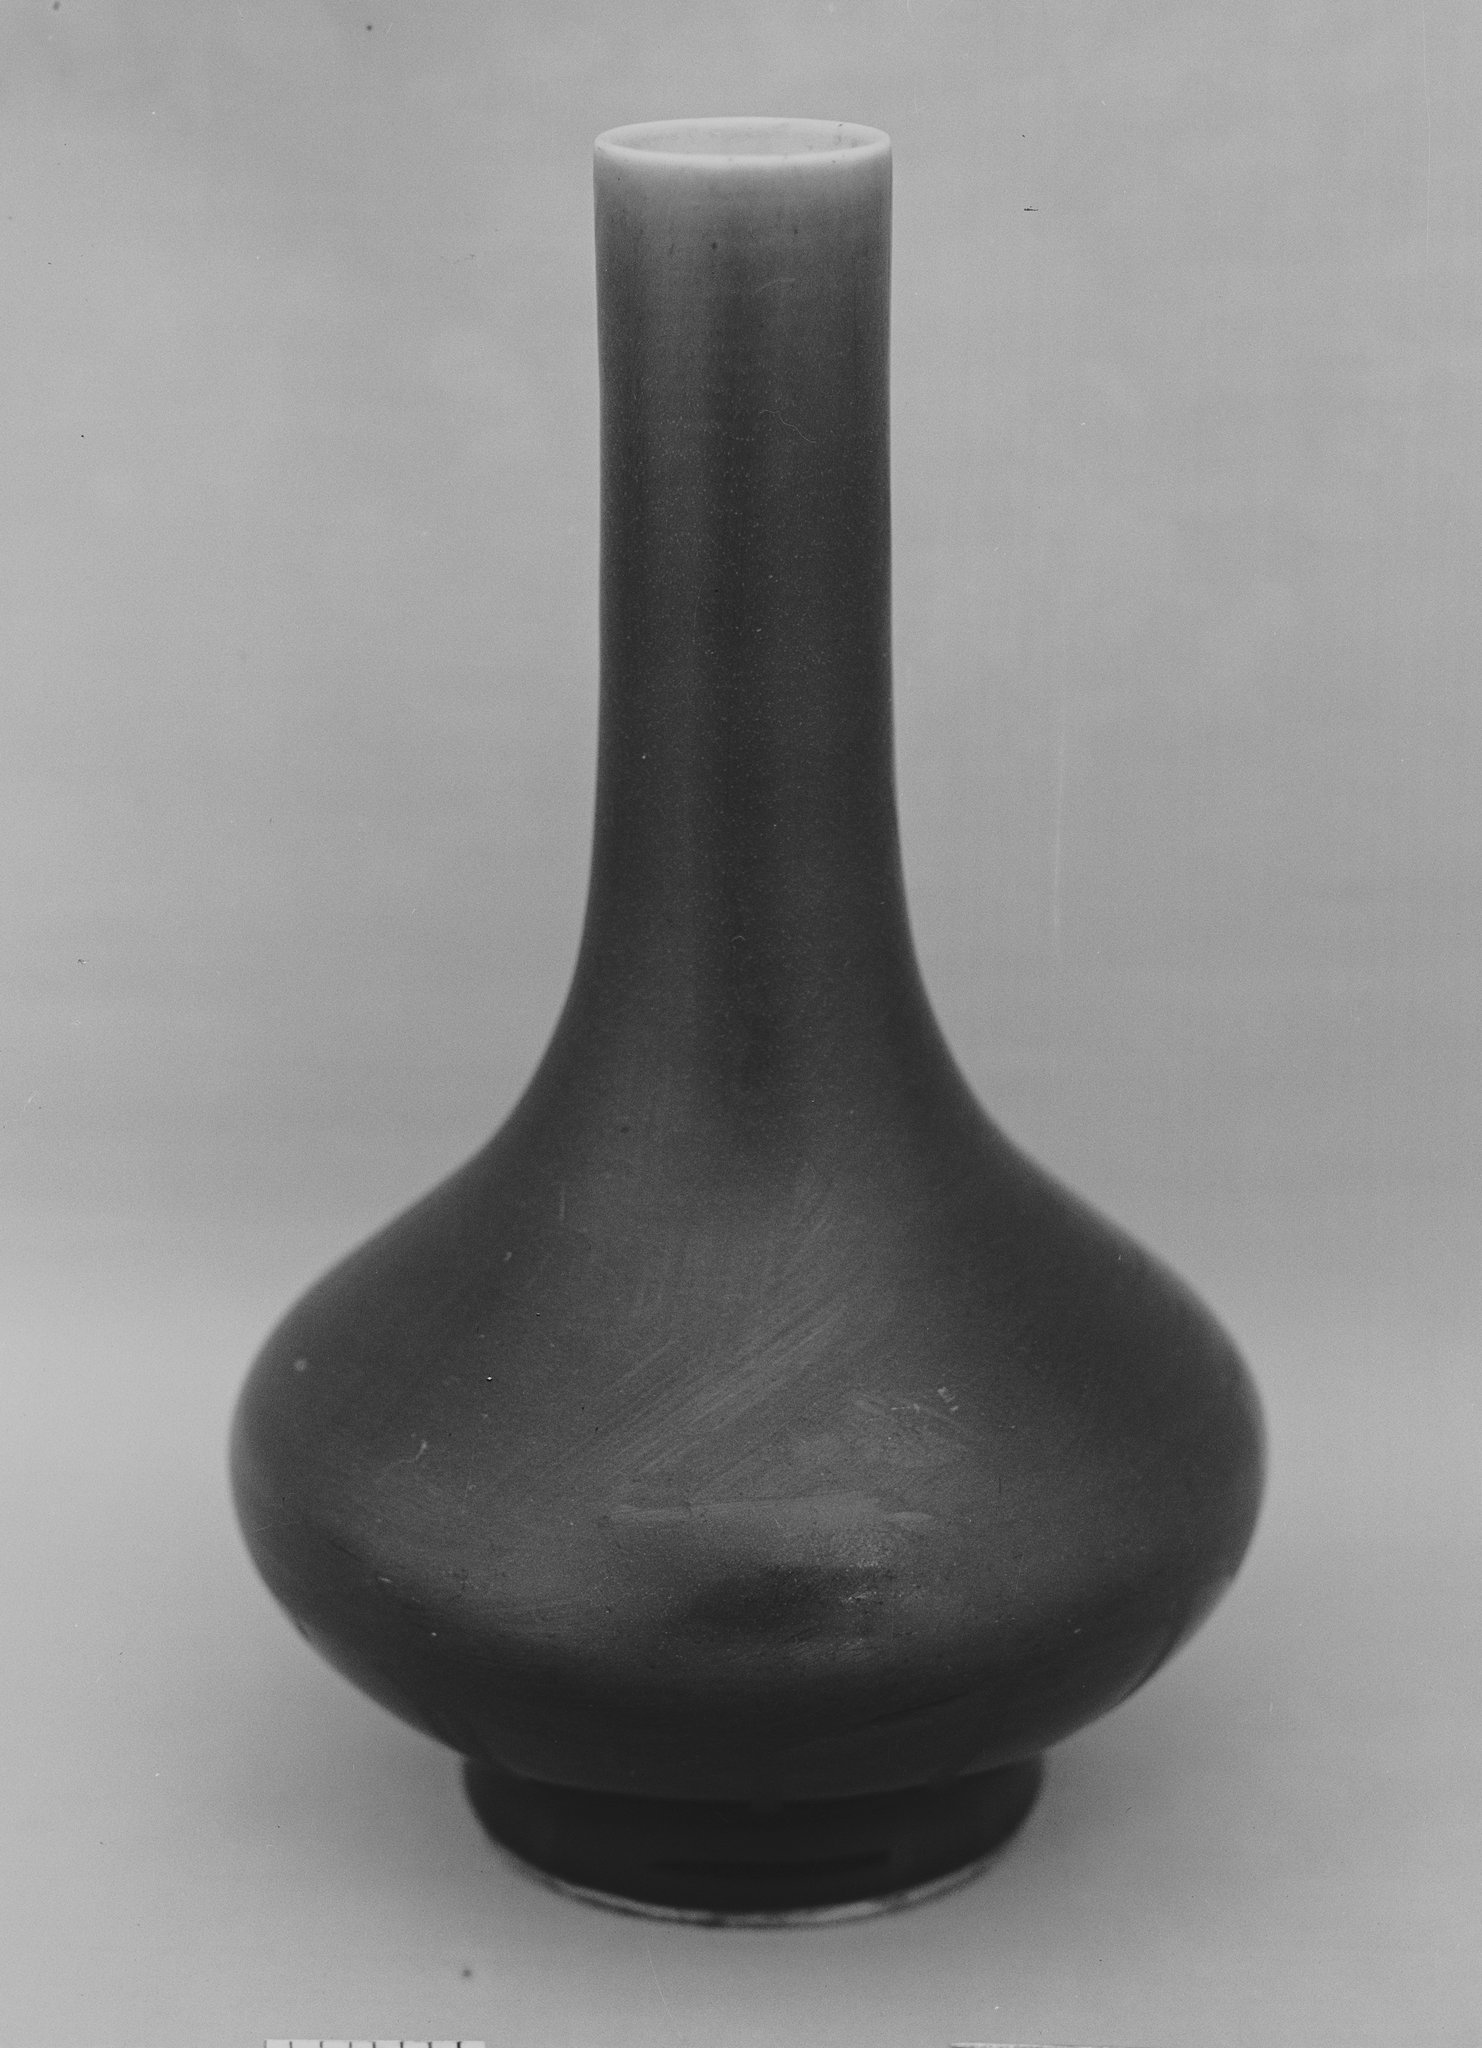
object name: bottle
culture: chinese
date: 1723-1735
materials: glaze, porcelain